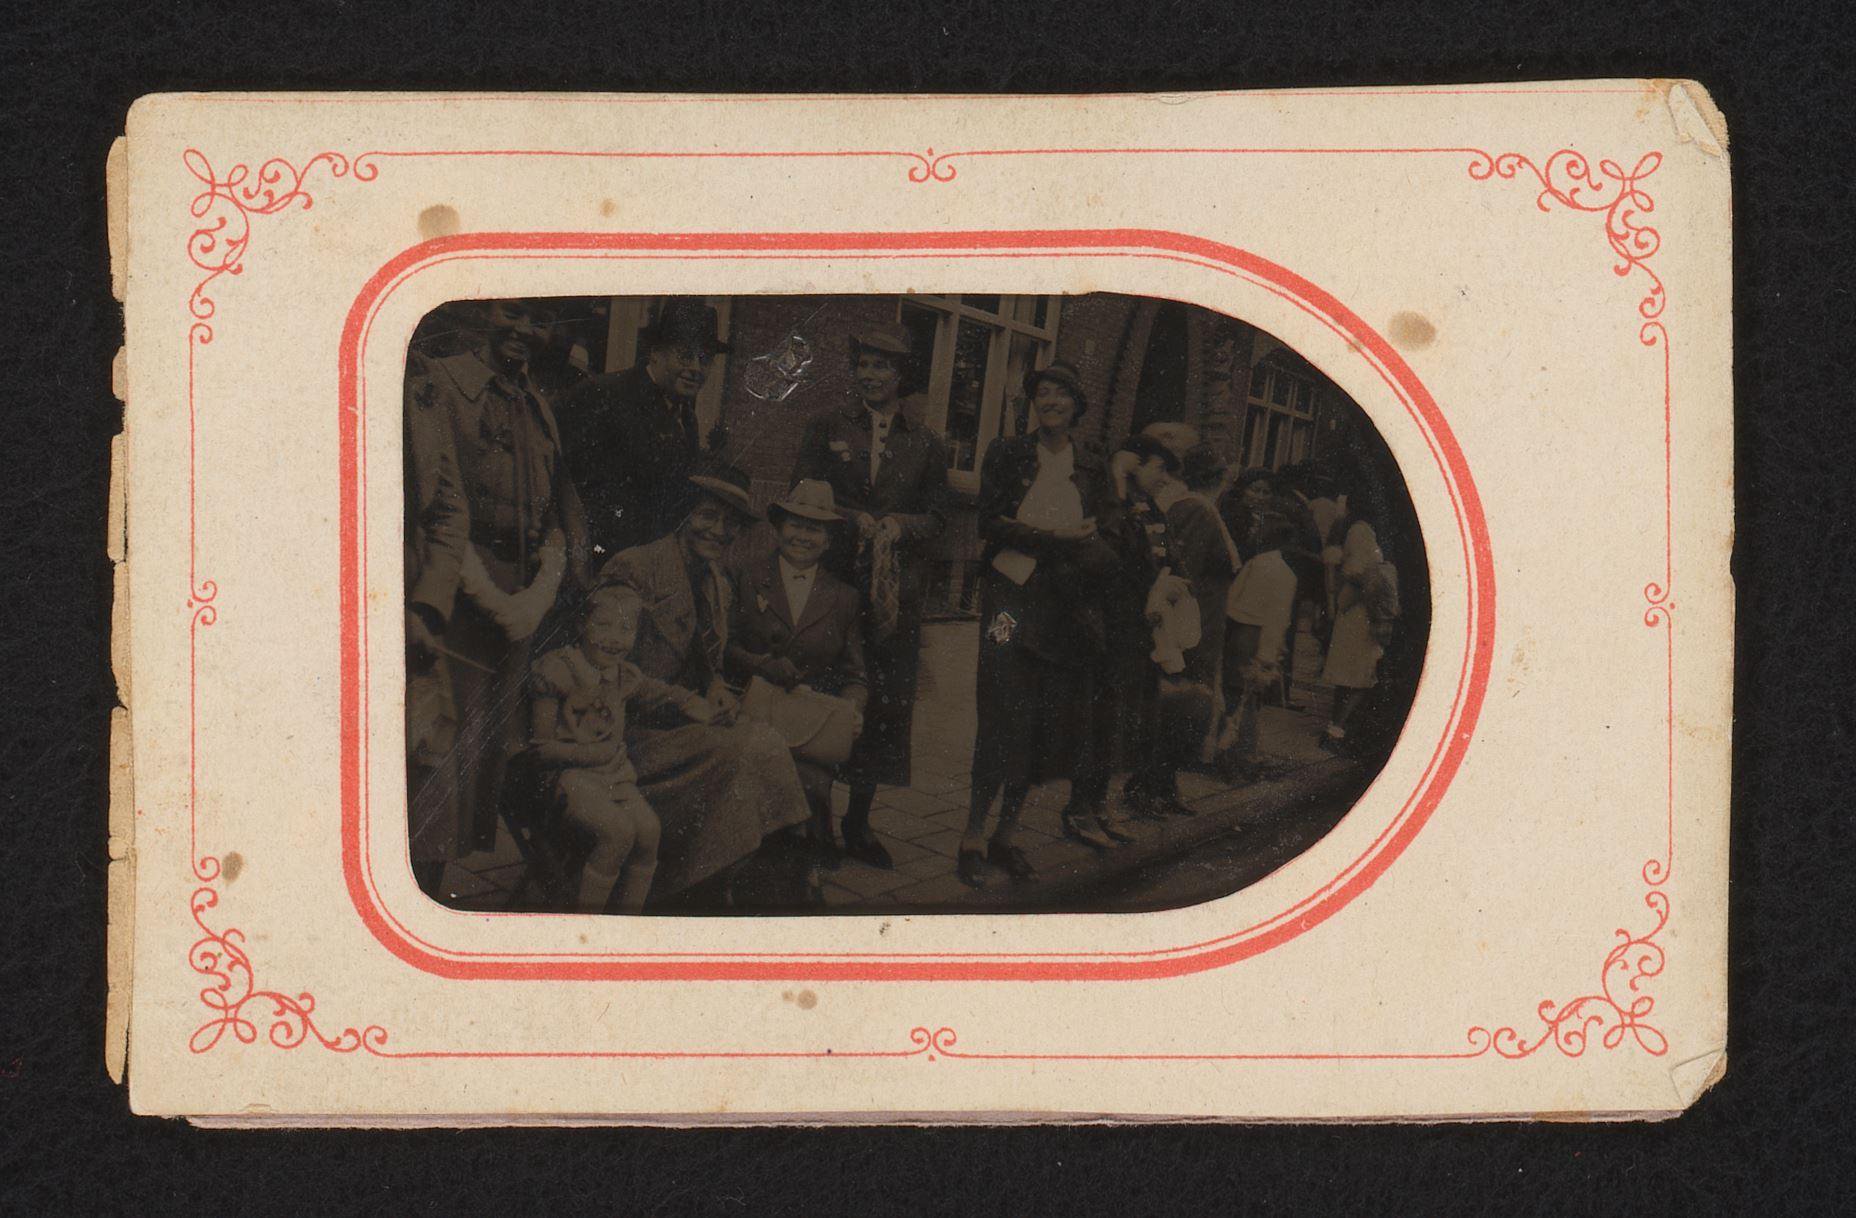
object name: photograph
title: Groep mensen op straat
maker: Anonymous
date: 1870-1882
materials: iron, paper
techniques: ferrotyping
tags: adult woman, adult man, child, historical persons, street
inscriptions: number: ‘1129’